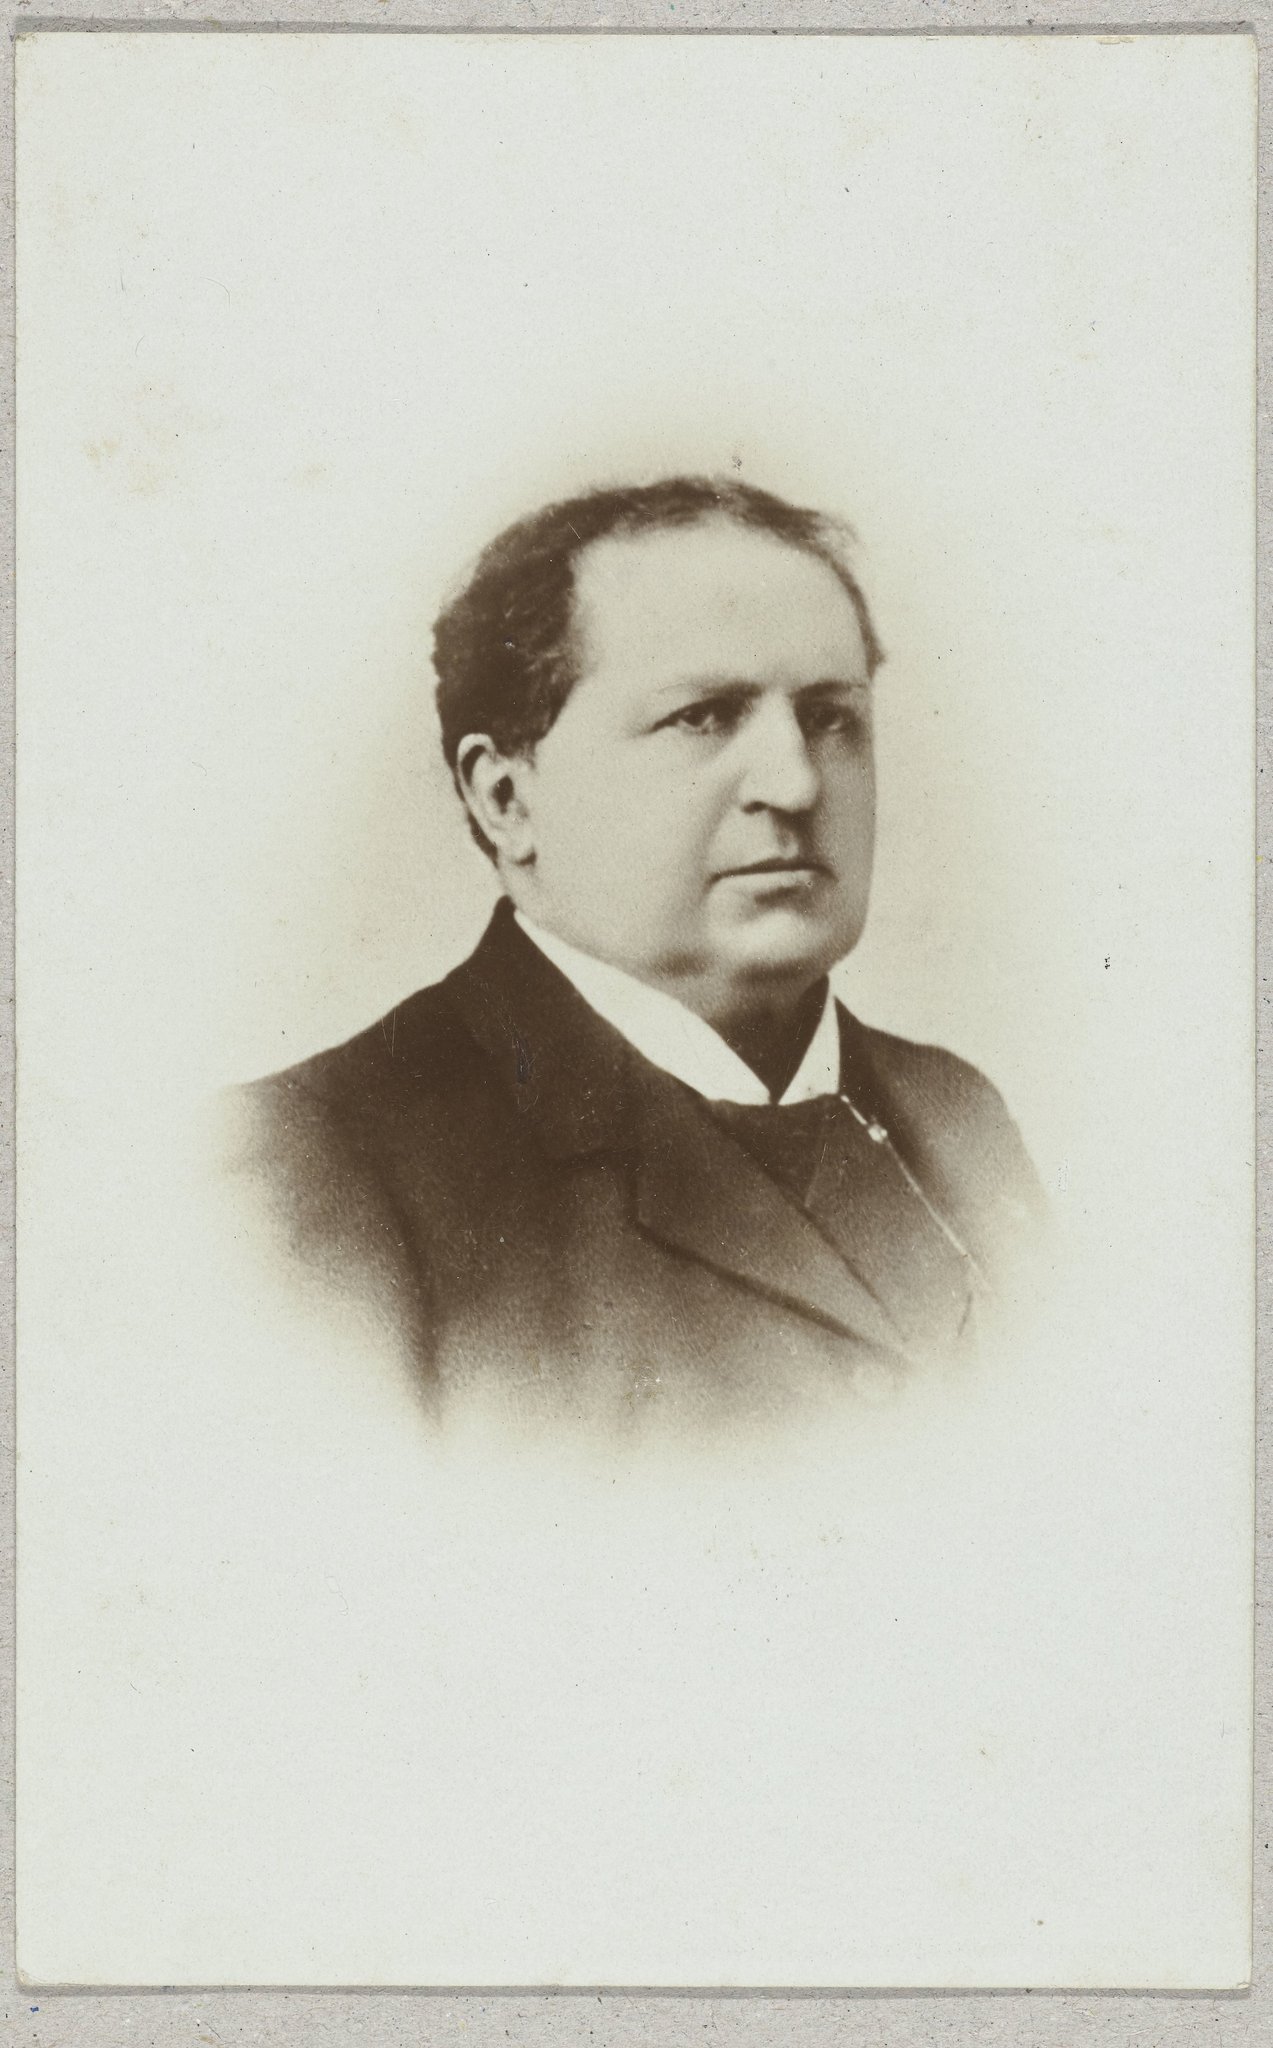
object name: photograph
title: Portret van Dr. Abraham Kuyper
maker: Anonymous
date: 1880-1920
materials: paper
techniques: gelatin silver print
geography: netherlands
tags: the hague, abraham kuyper, historical persons